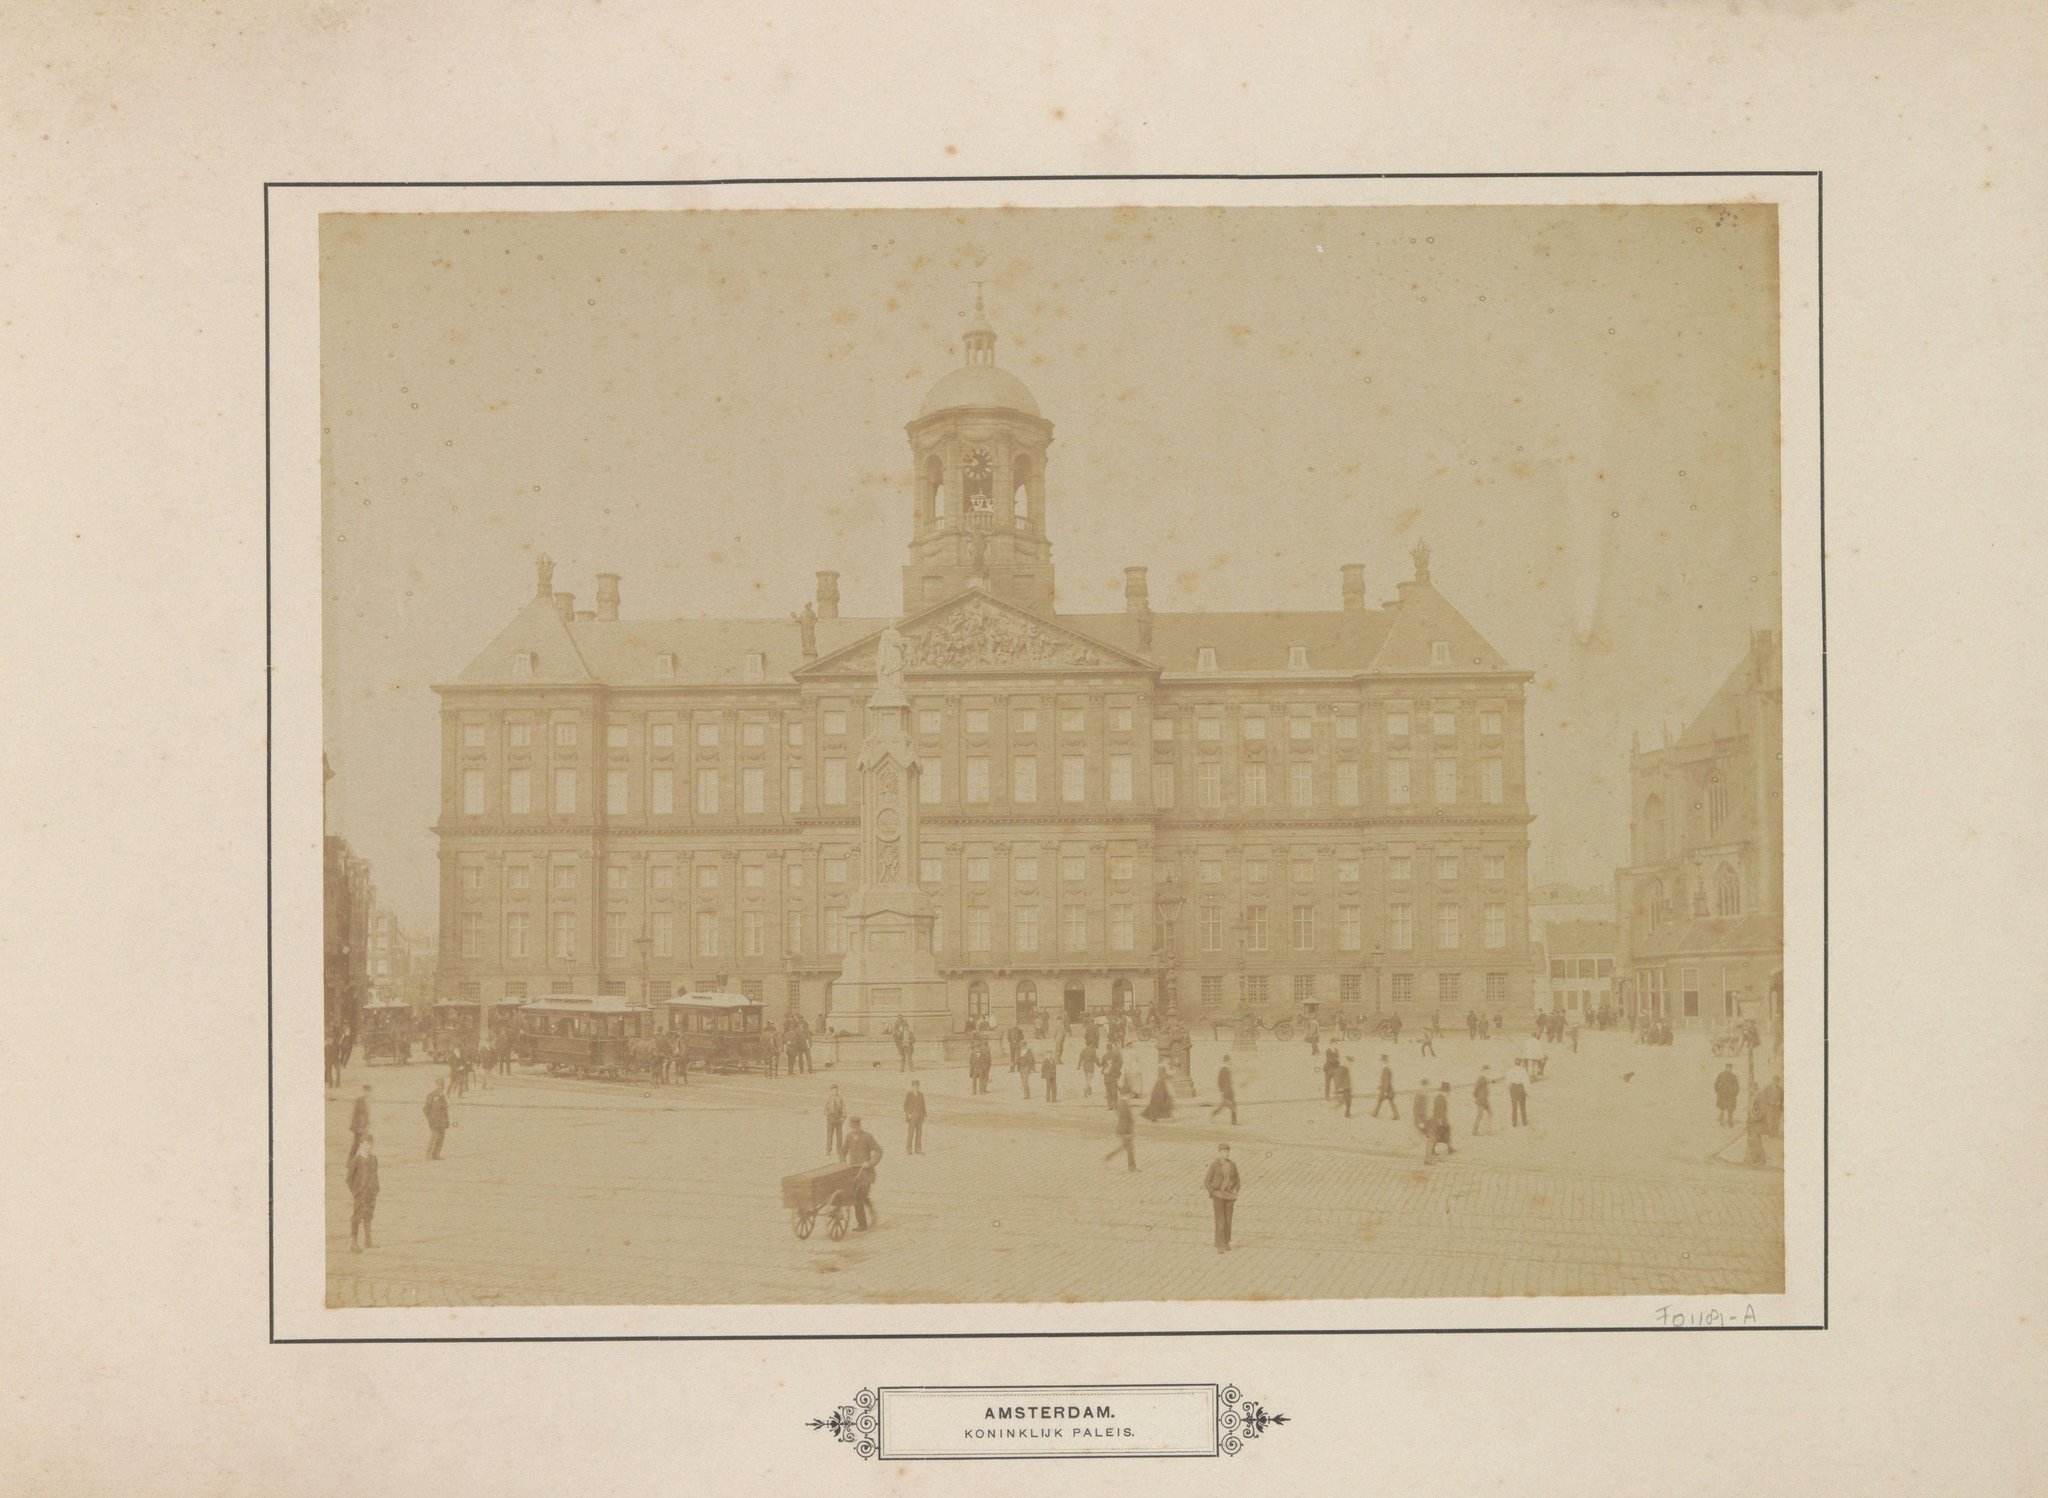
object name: photograph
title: Amsterdam, Koninklijk Paleis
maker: Anonymous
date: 1880-1895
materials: photographic support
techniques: albumen print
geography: dam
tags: diligence, omnibus, horse-tram, palace, monument, statue, square, place, circus, etc. (+ city(-scape) with figures, staffage), royal palace of amsterdam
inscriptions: inscription: ‘Hendrik Groote Kalverstraat 43, Amsterdam. Photographic stores. Views from Holland. Photographs from ancient and modern dutch Paintings. Fines ans most complete Collection.’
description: Onderdeel van Fotoalbum met opnames van het centrum van Amsterdam en reclameteksten voor winkels en bedrijven.